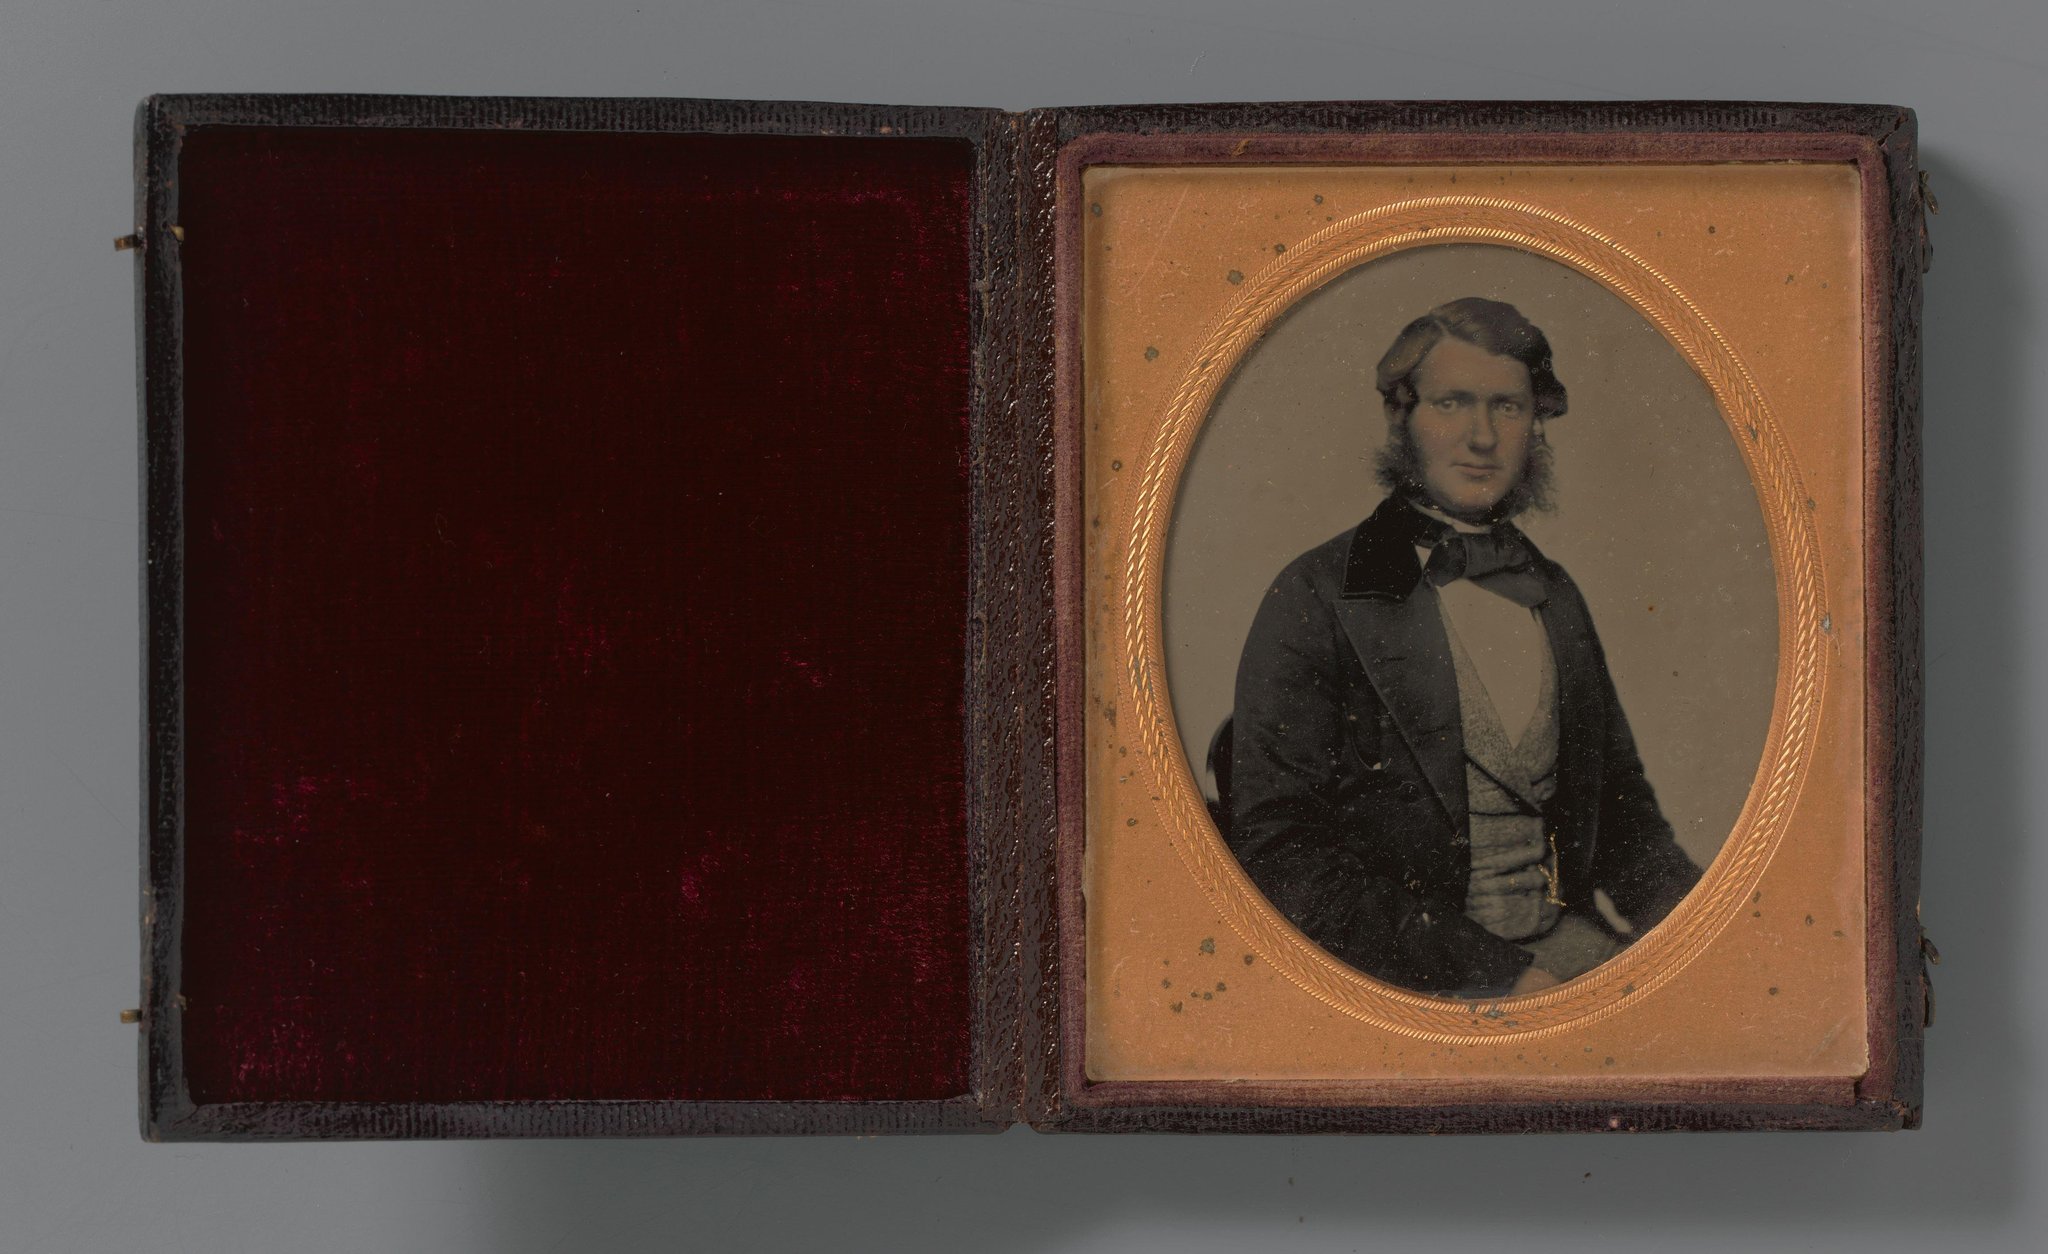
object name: photograph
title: Portret van een onbekende man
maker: Anonymous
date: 1855-1870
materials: glass, metal, velvet, wood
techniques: ambrotype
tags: sideburns, historical persons